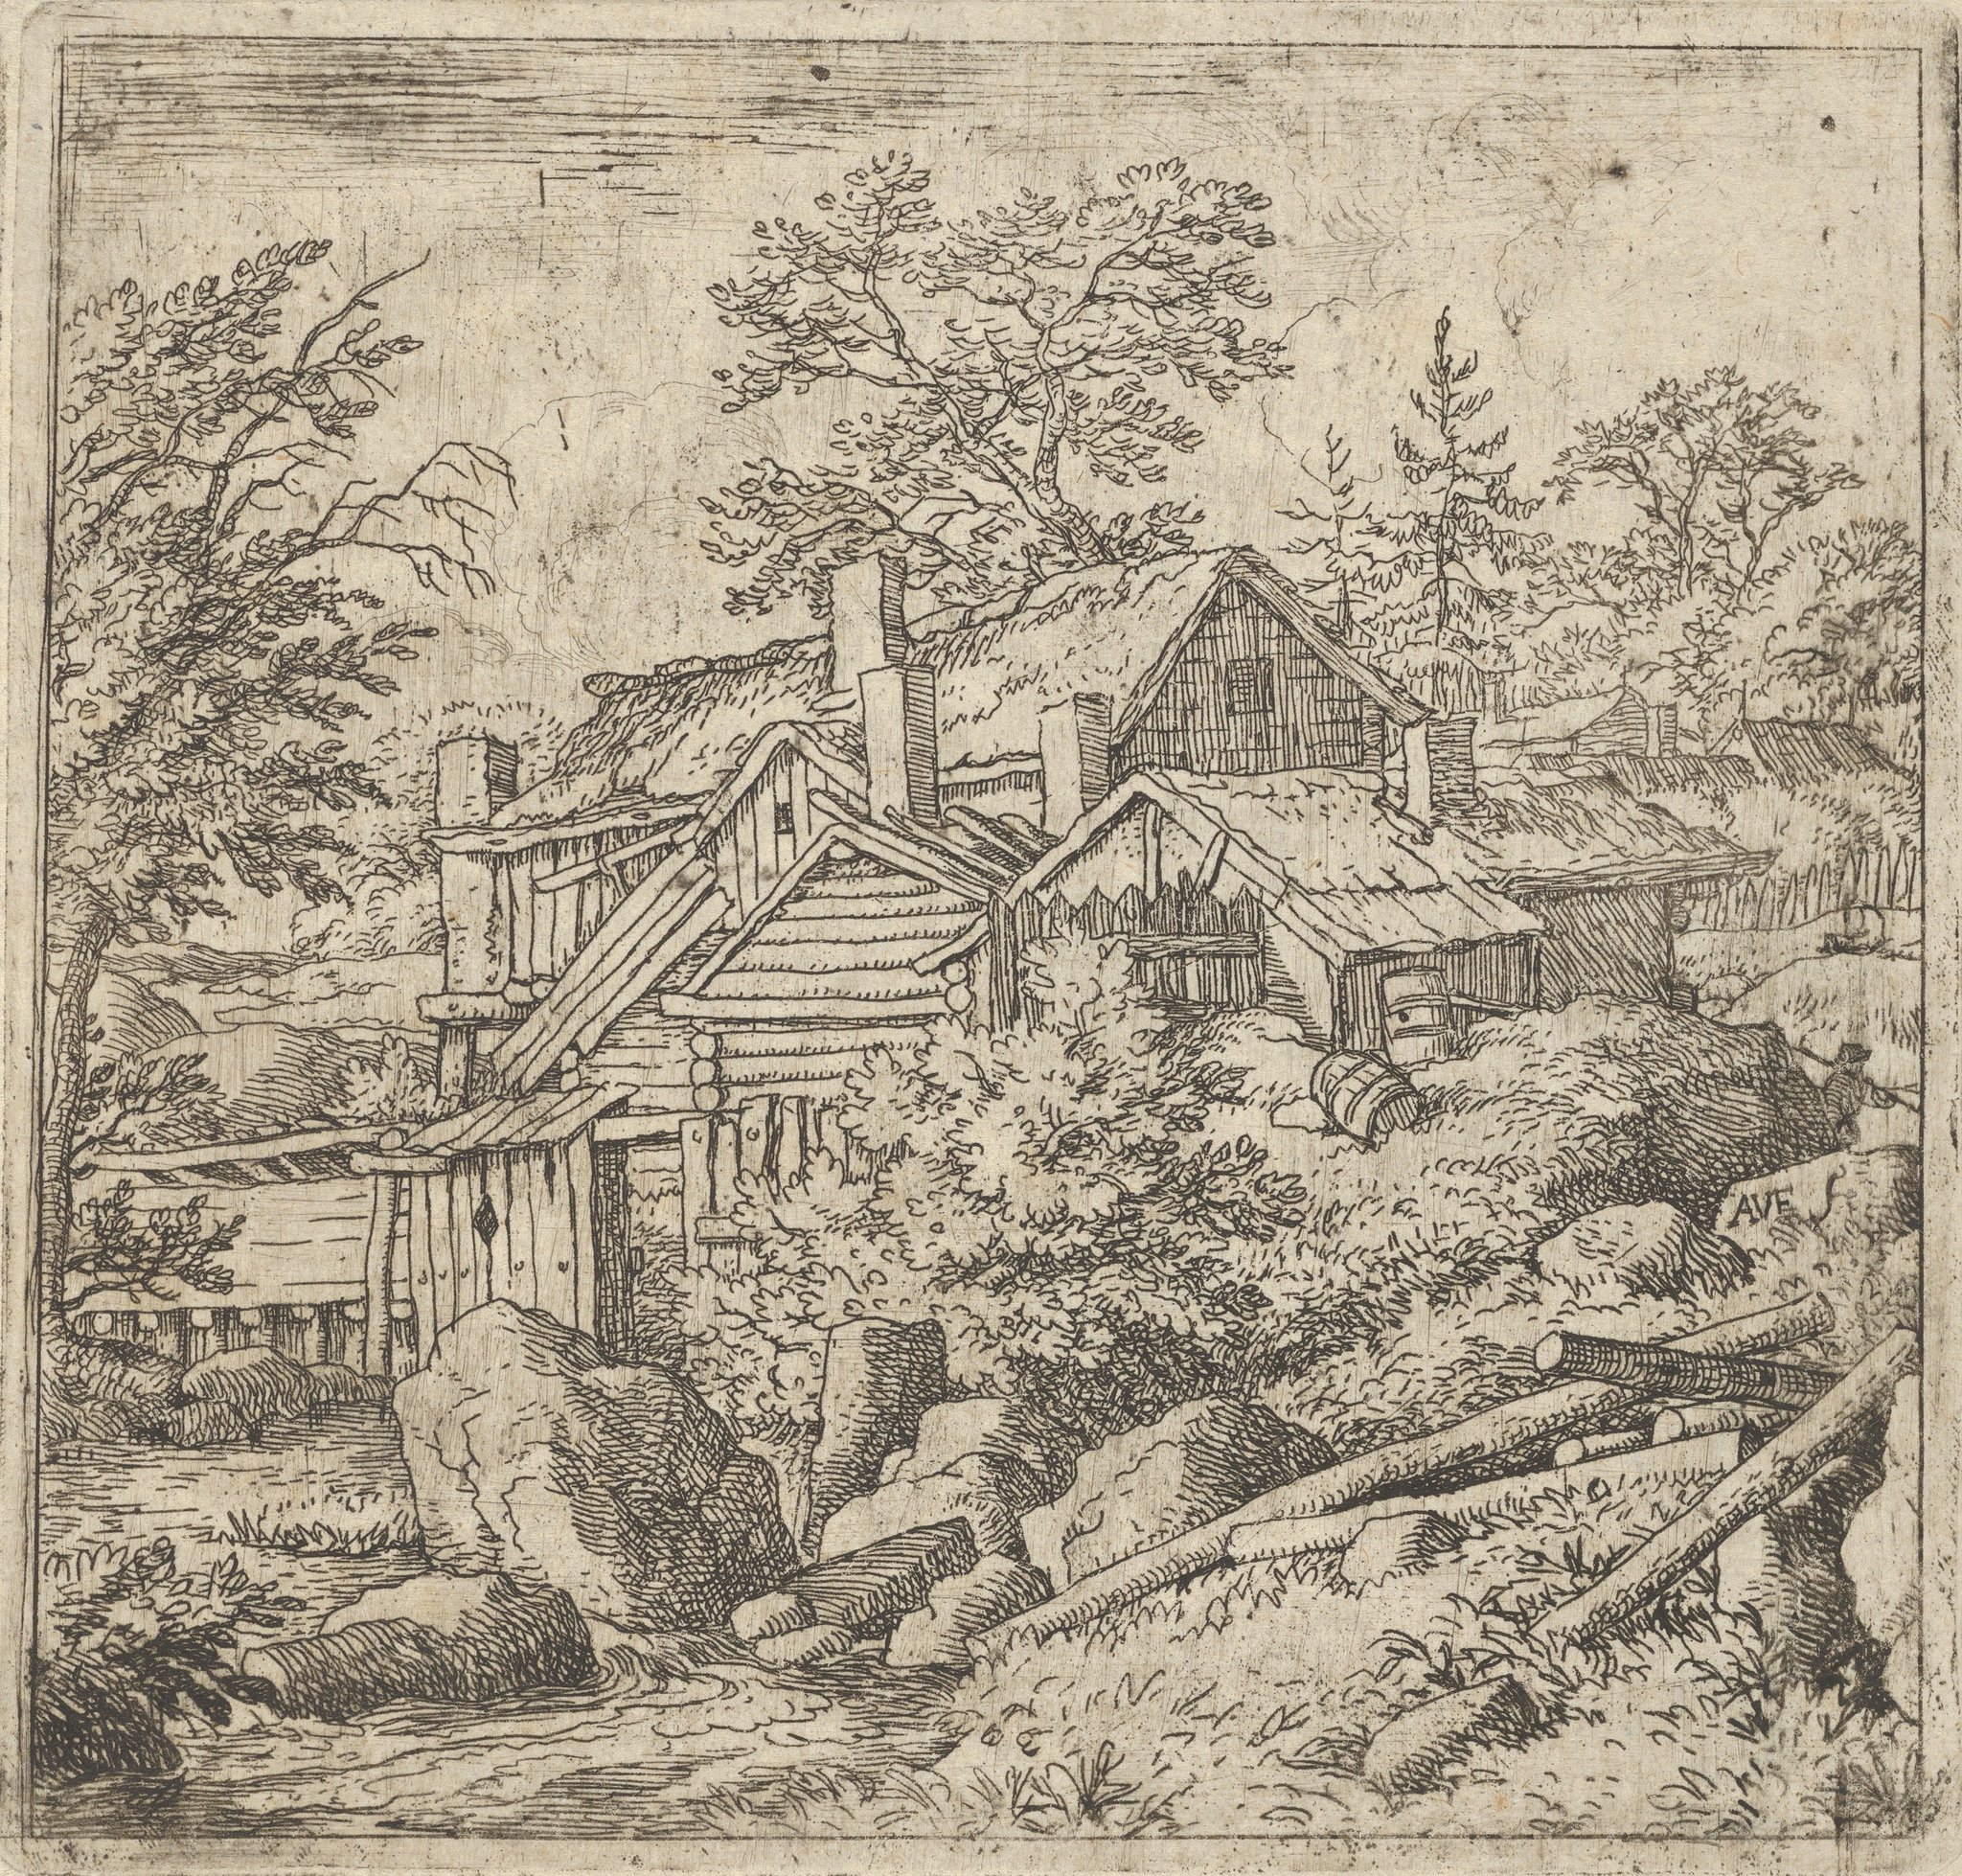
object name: print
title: The Hamlet on the Mountainside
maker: allart van everdingen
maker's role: artist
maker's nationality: dutch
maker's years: 1621-1675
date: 1621-1675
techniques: engraving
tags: houses,landscapes,trees